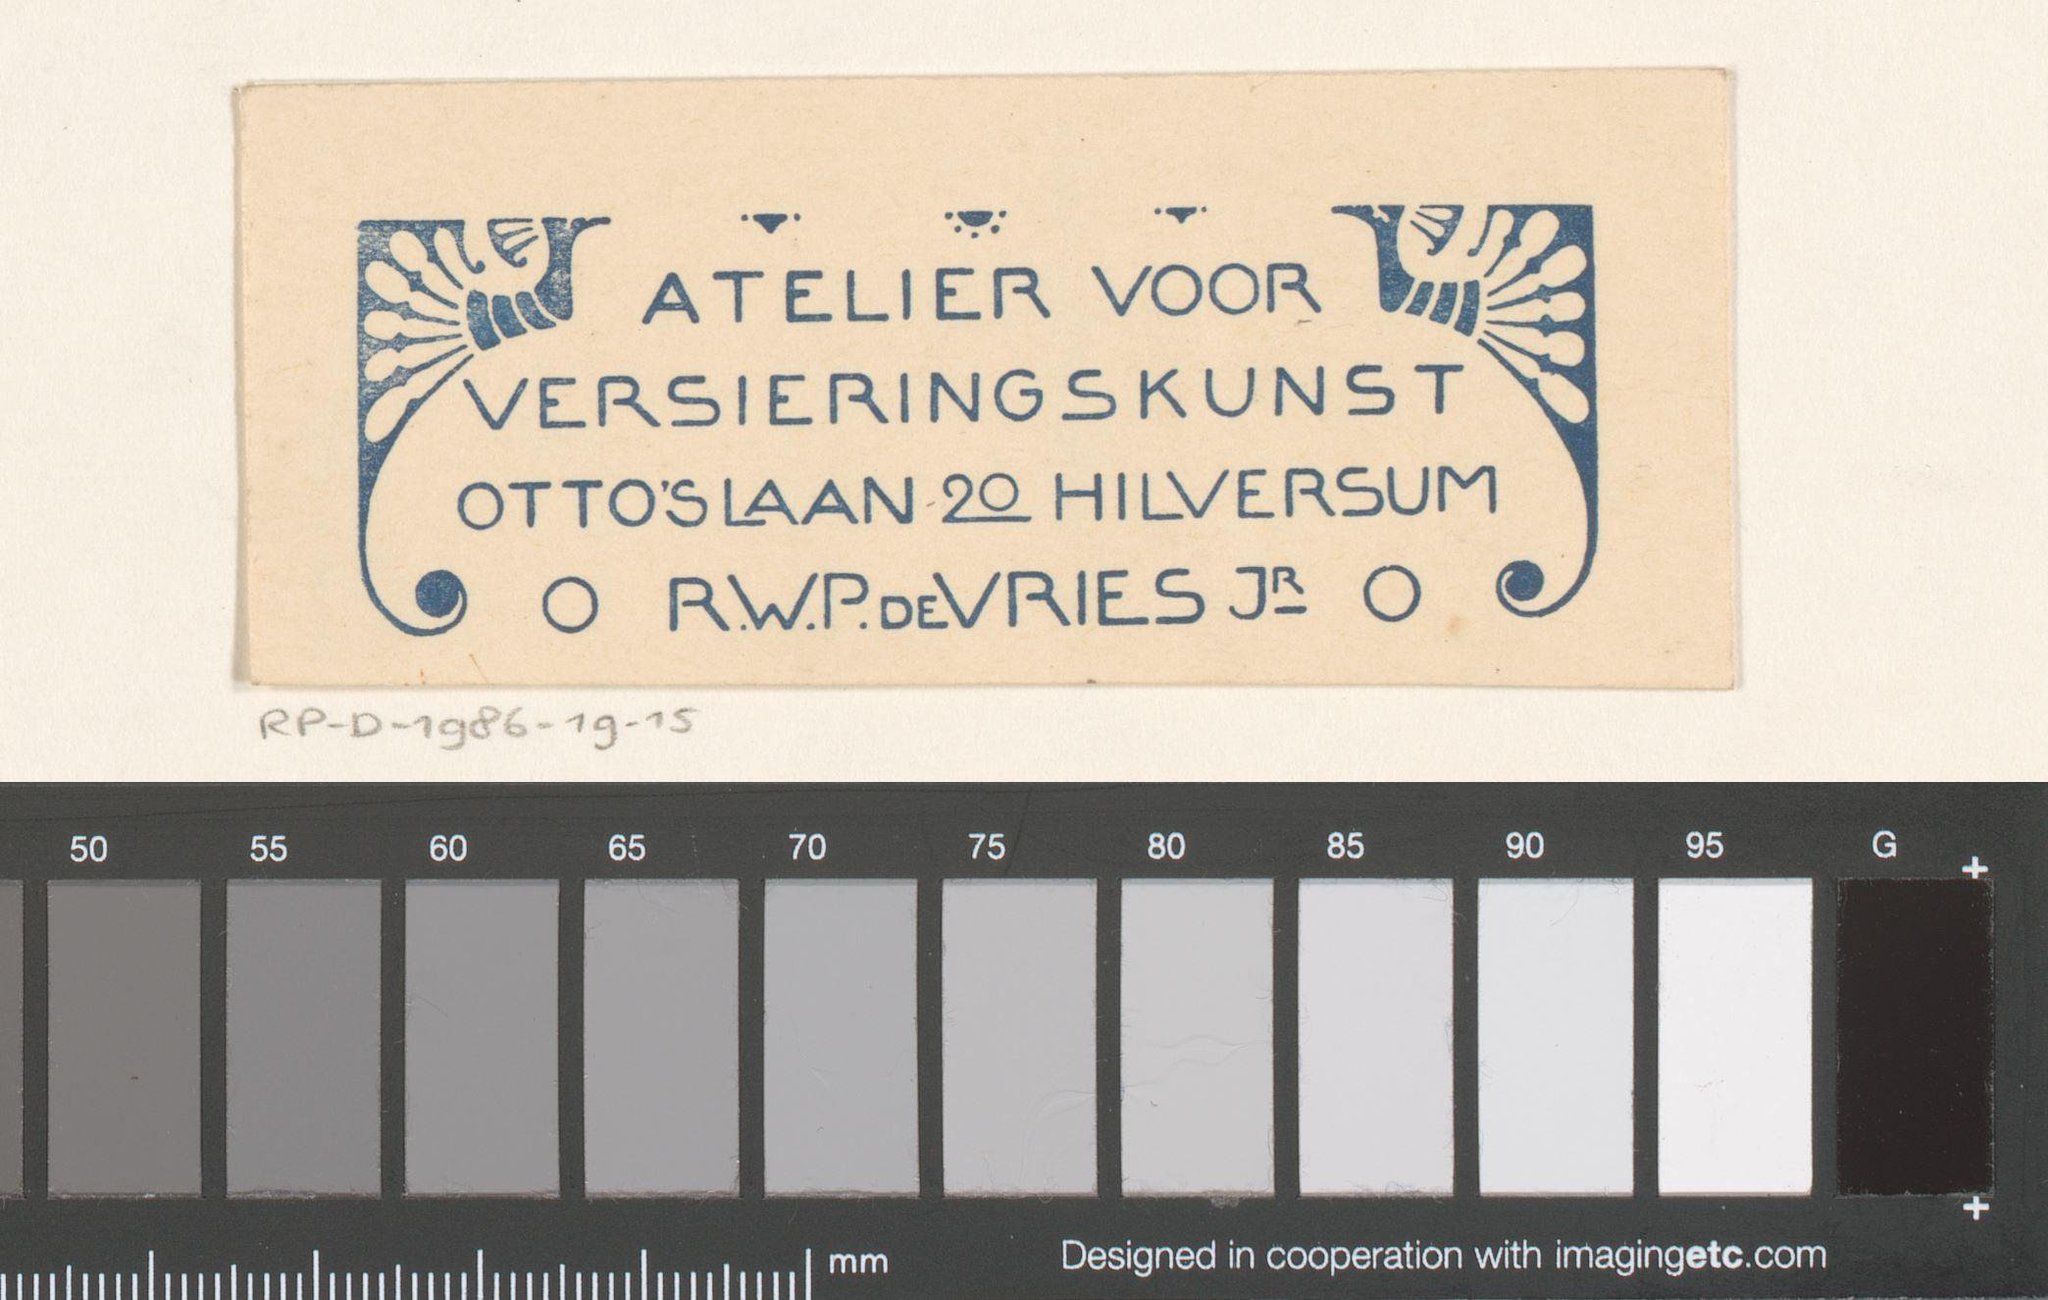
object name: print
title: Vignet van Atelier voor Versieringskunst te Hilversum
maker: reinier willem petrus de vries (1874-1953)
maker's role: draughtsman, print maker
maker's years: 1874-1953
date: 1884-1952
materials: paper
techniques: relief print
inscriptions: address: ‘[...] Reisbureau/ Lindeman/ mar[...]/ Haag’, collector's mark: ‘R:MVS.’